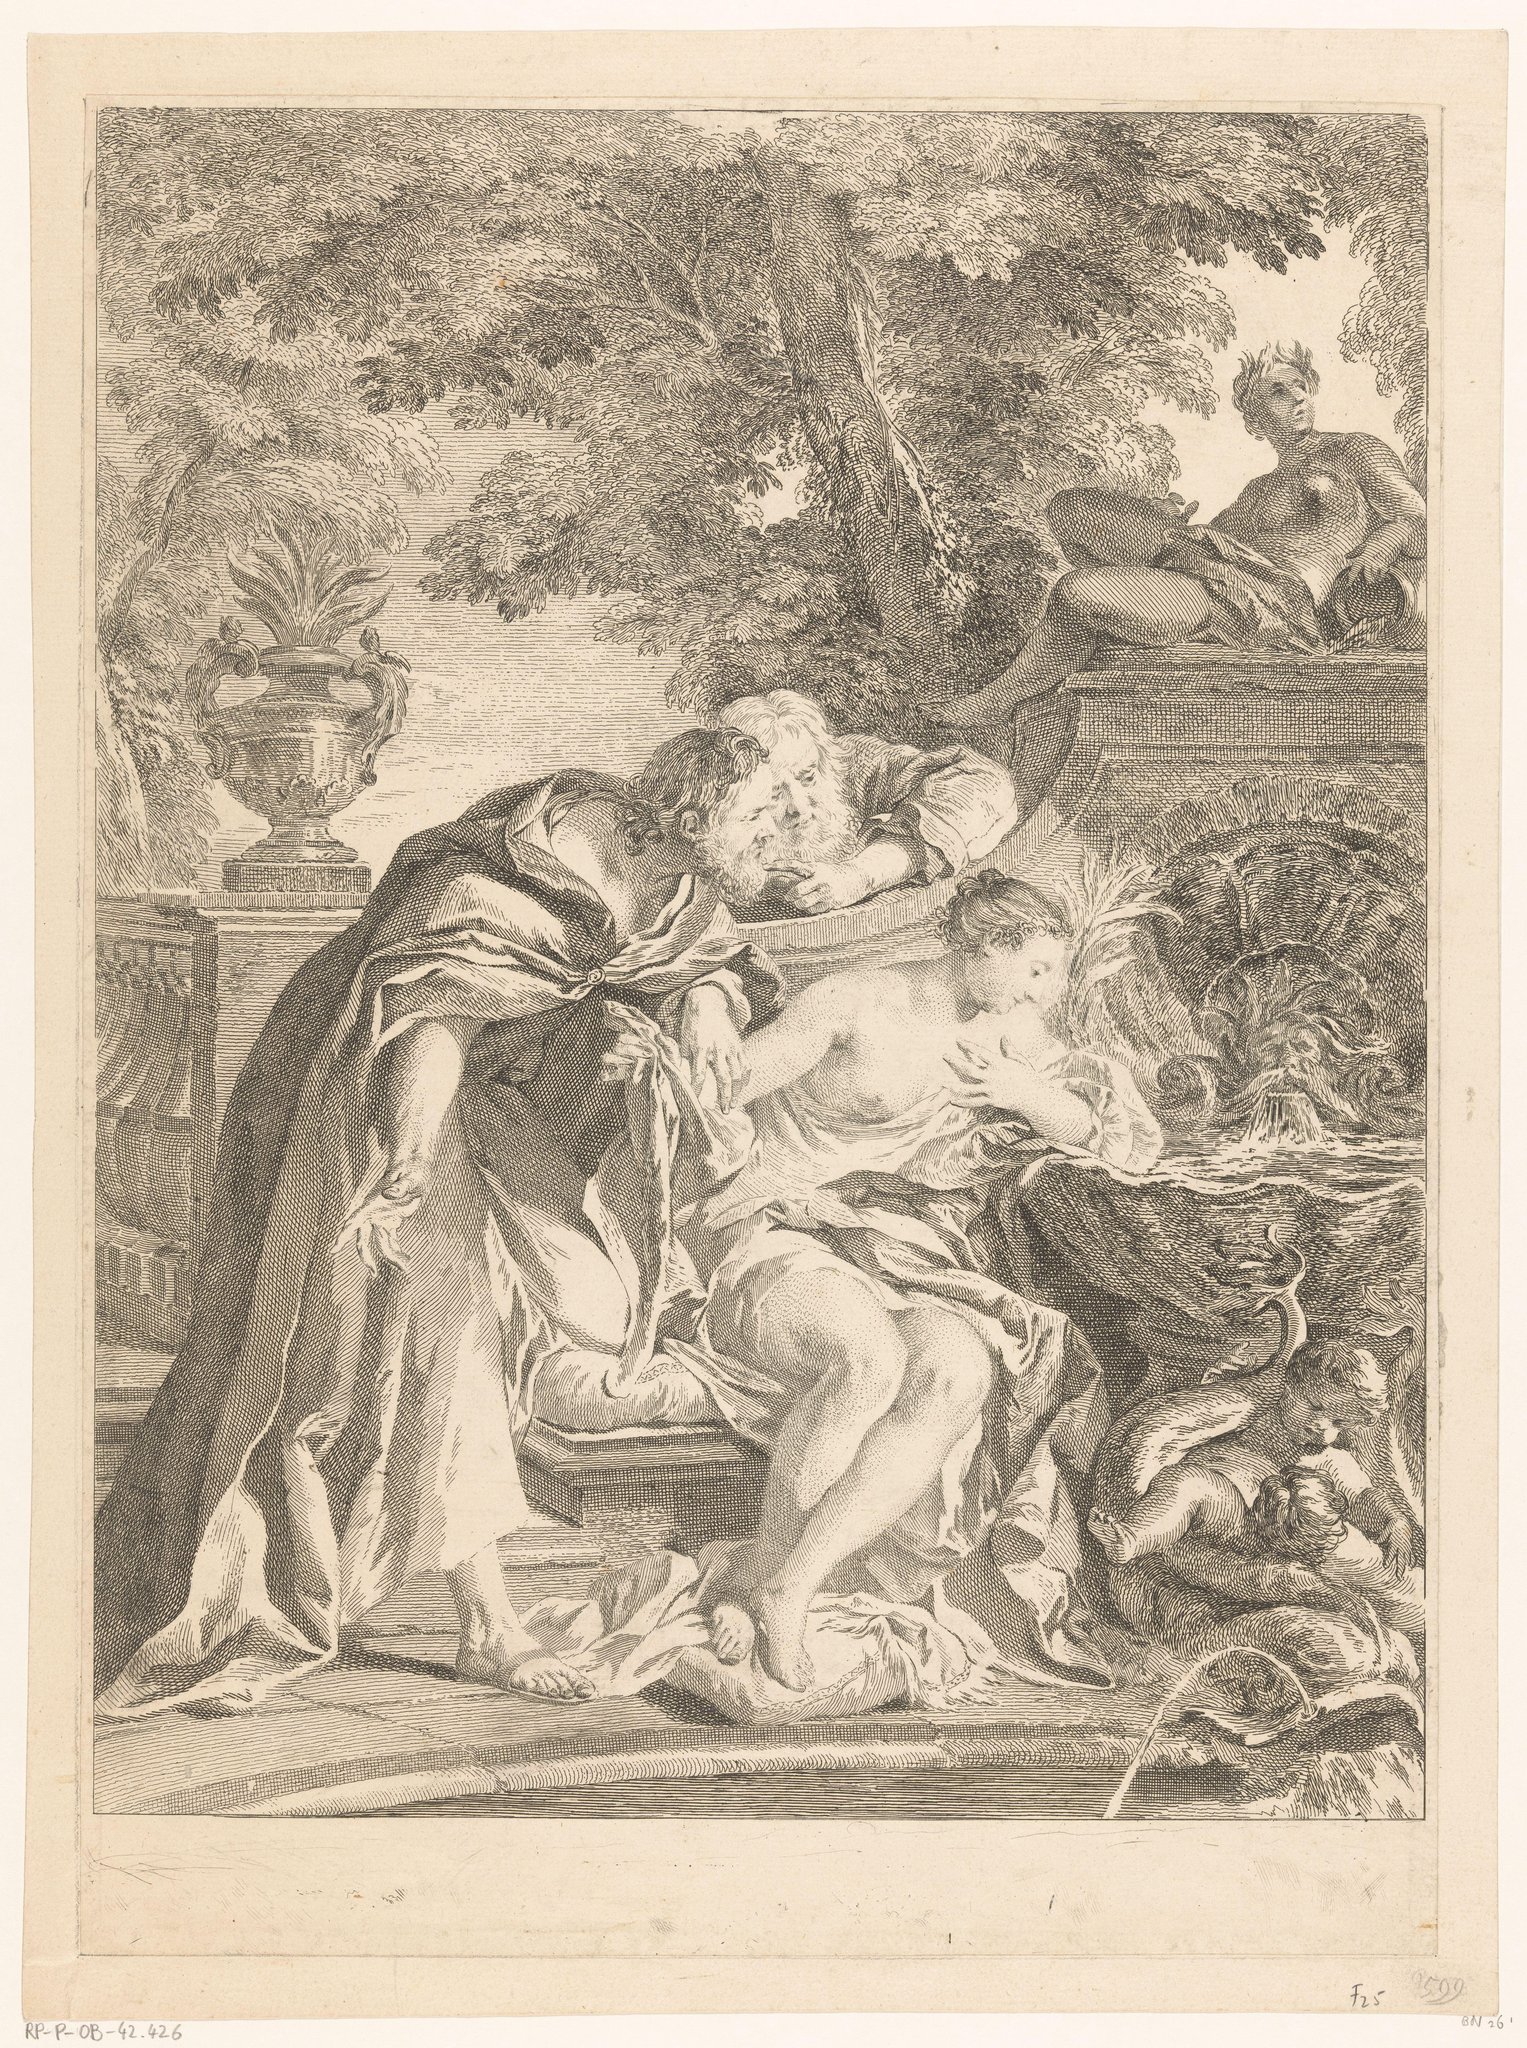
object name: print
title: Suzanna en de ouderlingen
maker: laurent cars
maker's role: print maker, publisher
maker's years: 1699-1771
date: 1731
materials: paper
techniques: engraving, etching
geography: france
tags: the elders making advances towards susanna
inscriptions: collector's mark: Lugt 240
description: Het schilderij door De Troy werd in 1727 vervaardigd en bevindt zich in de collectie van het Musée des Beaux-Arts de Rouen, inv.nr. 891.1.